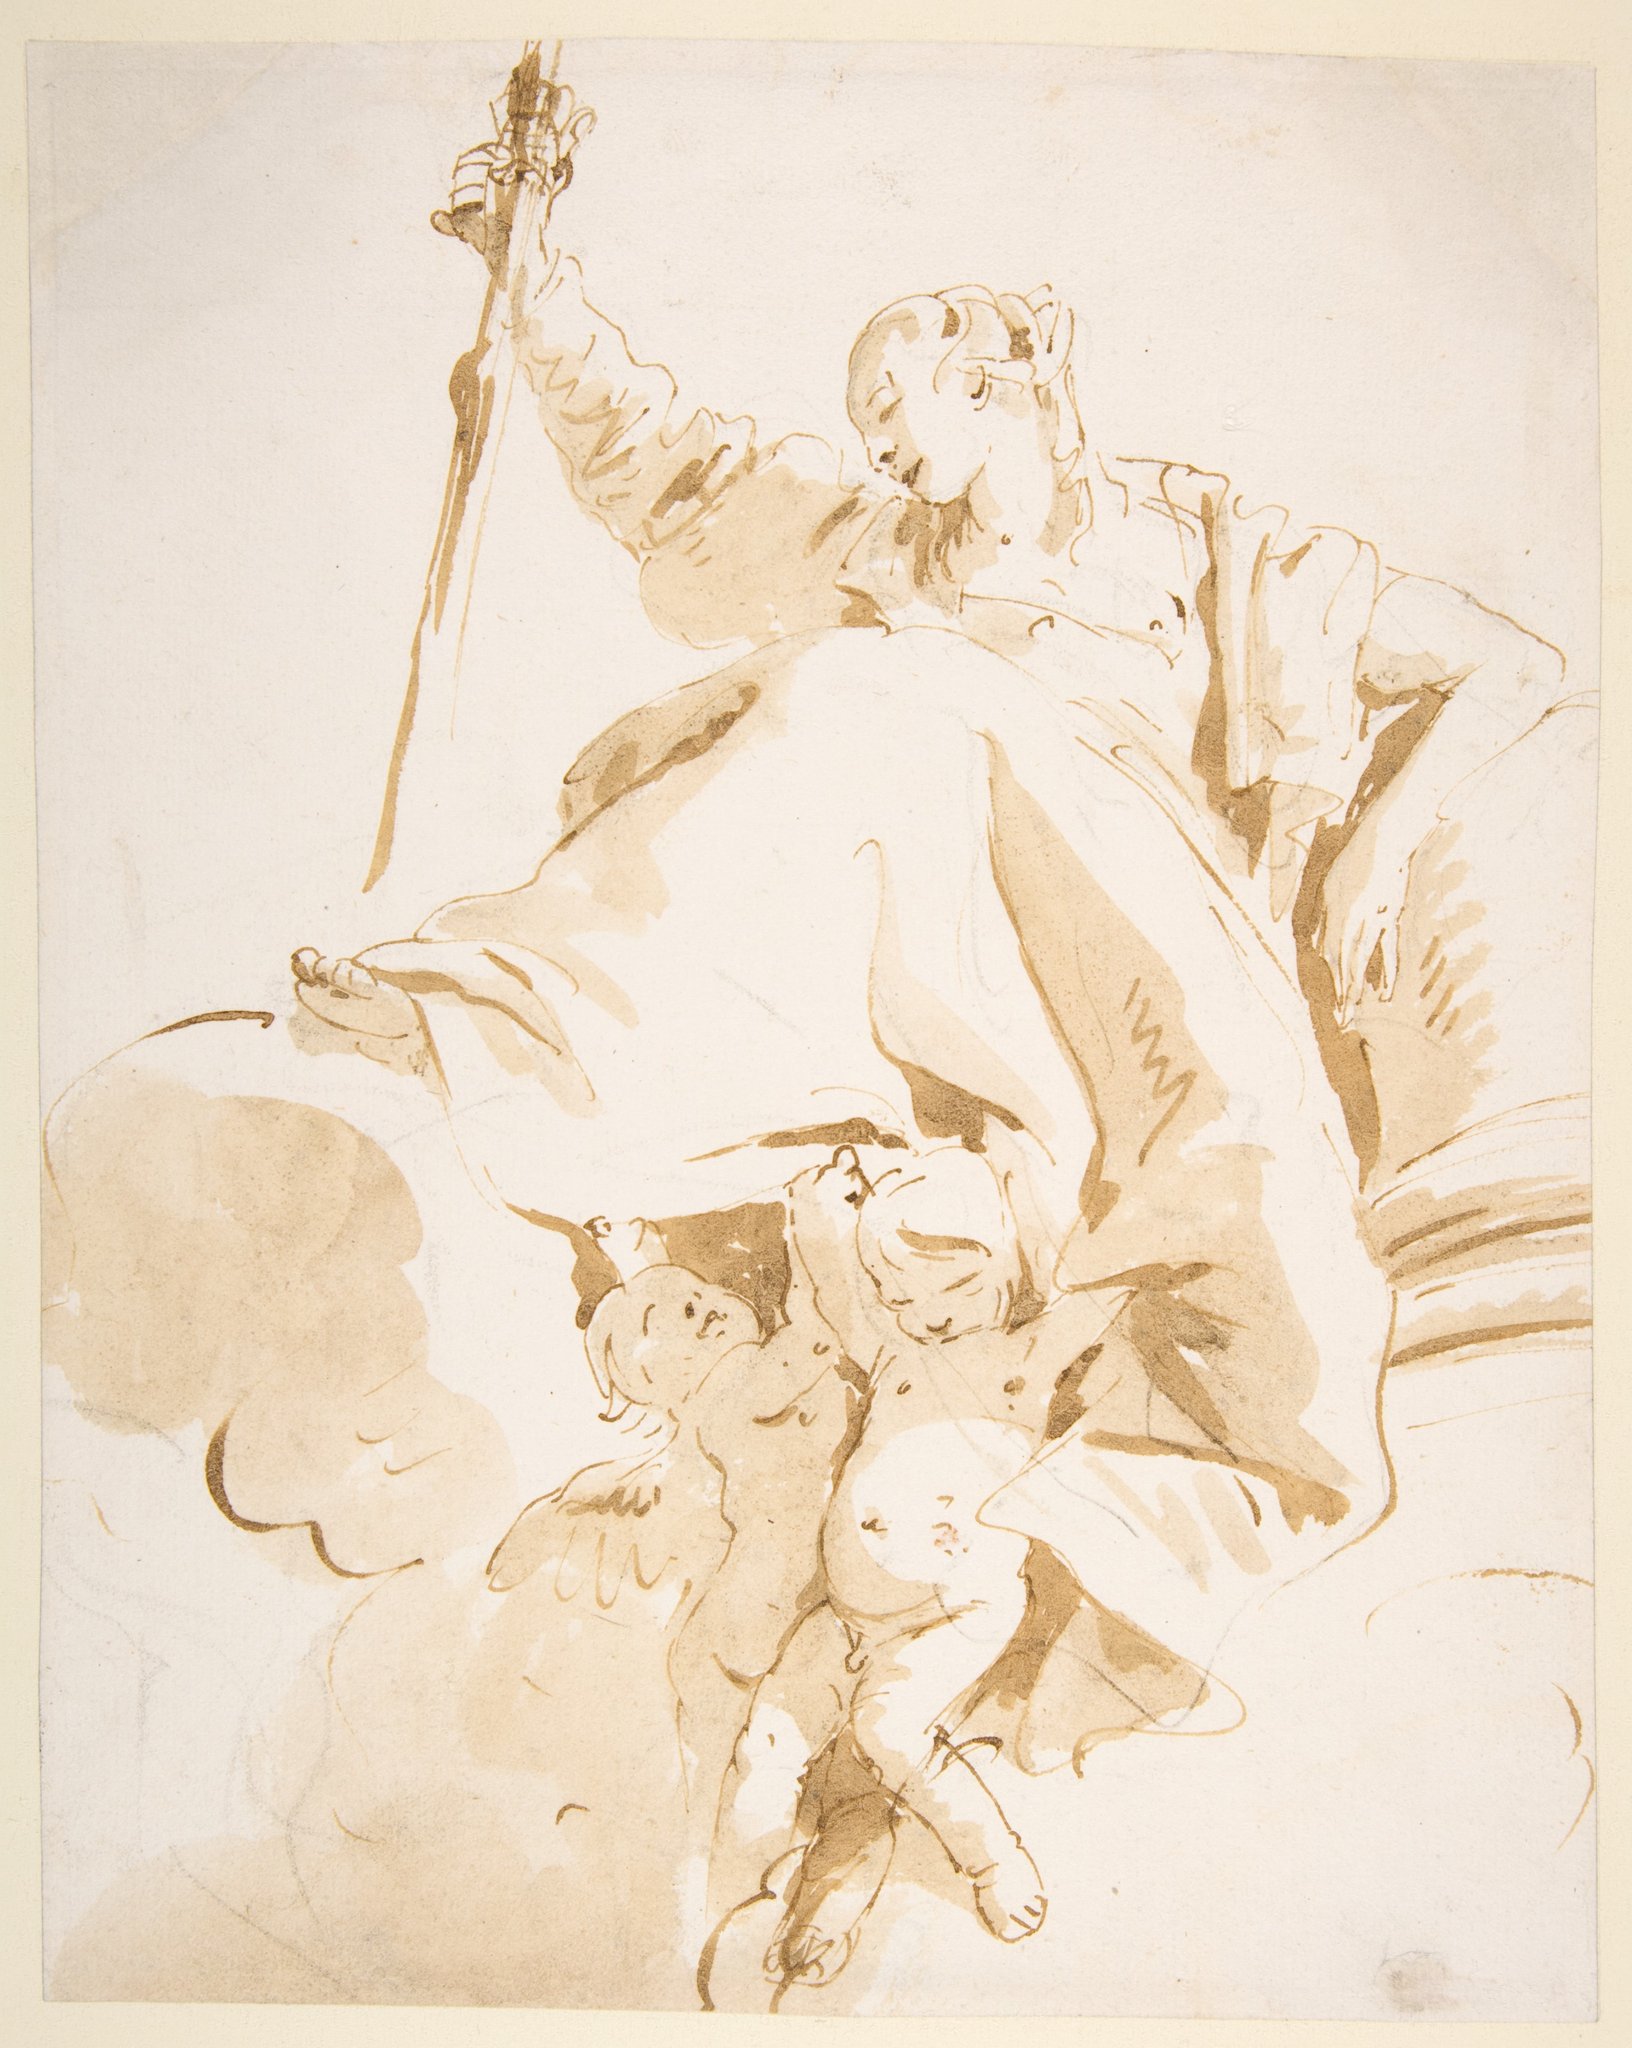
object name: drawing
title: Seated Women Holding Aloft a Sword, and Supported by Two Putti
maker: giovanni battista tiepolo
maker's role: artist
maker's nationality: italian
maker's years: 1696-1770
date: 1696-1770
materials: chalk, ink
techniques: brush, pen, wash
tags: women